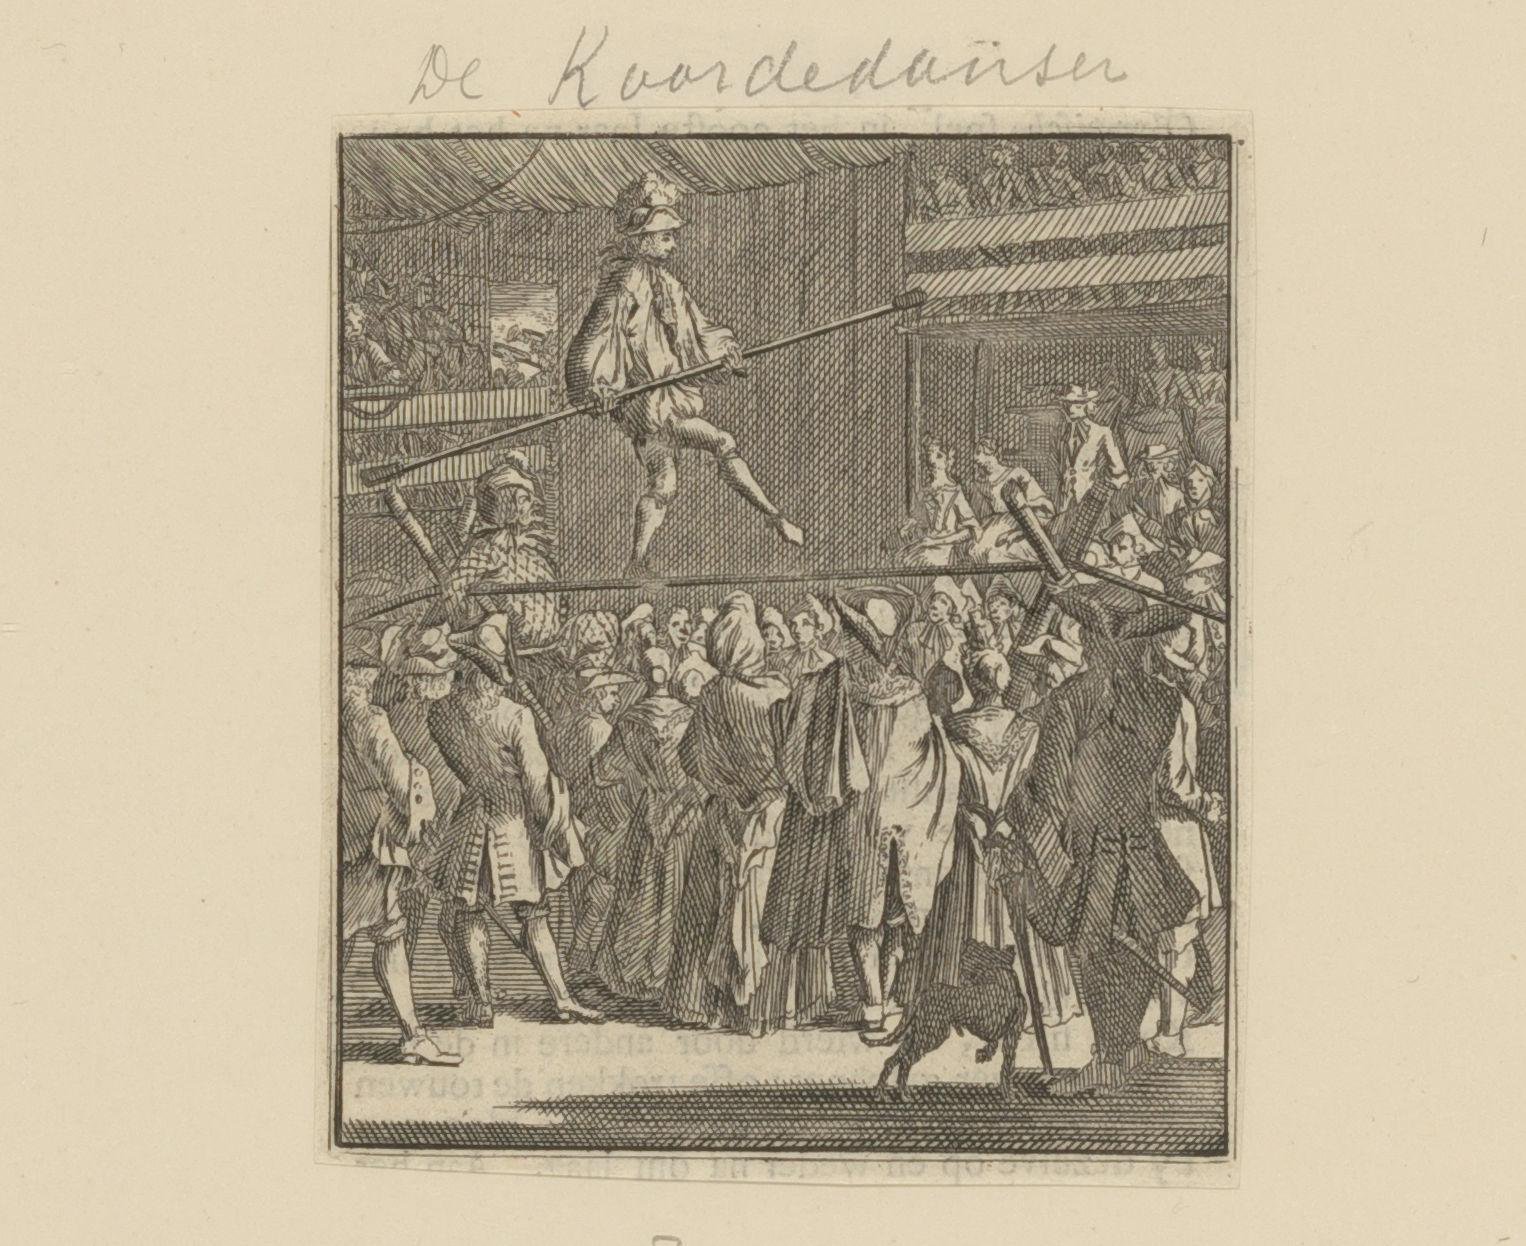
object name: print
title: Koorddanser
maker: Anonymous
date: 1719-1759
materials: paper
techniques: etching, letterpress printing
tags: ropery, rope-walk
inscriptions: collector's mark: Lugt 1641, stamp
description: Prent met andere letterzetting gebruikt in: St. Clara, Abraham van. Iets voor allen. [Vertaald door] J. le Long. Amsterdam: Janssoons van Waesberge, 1719, dl. 2. En in: St. Clara, Abraham van. Iets voor allen. [Vertaald door] J. le Long. Amsterdam: Jan Roman de Jonge, 1741, dl. 2. En in: St. Clara, Abraham van. Iets voor allen. [Vertaald door] J. le Long. Amsterdam: Jan Roman, 1759, dl. 2. Huidige prent uit een andere editie. Naar een prent van: Jan Luyken.